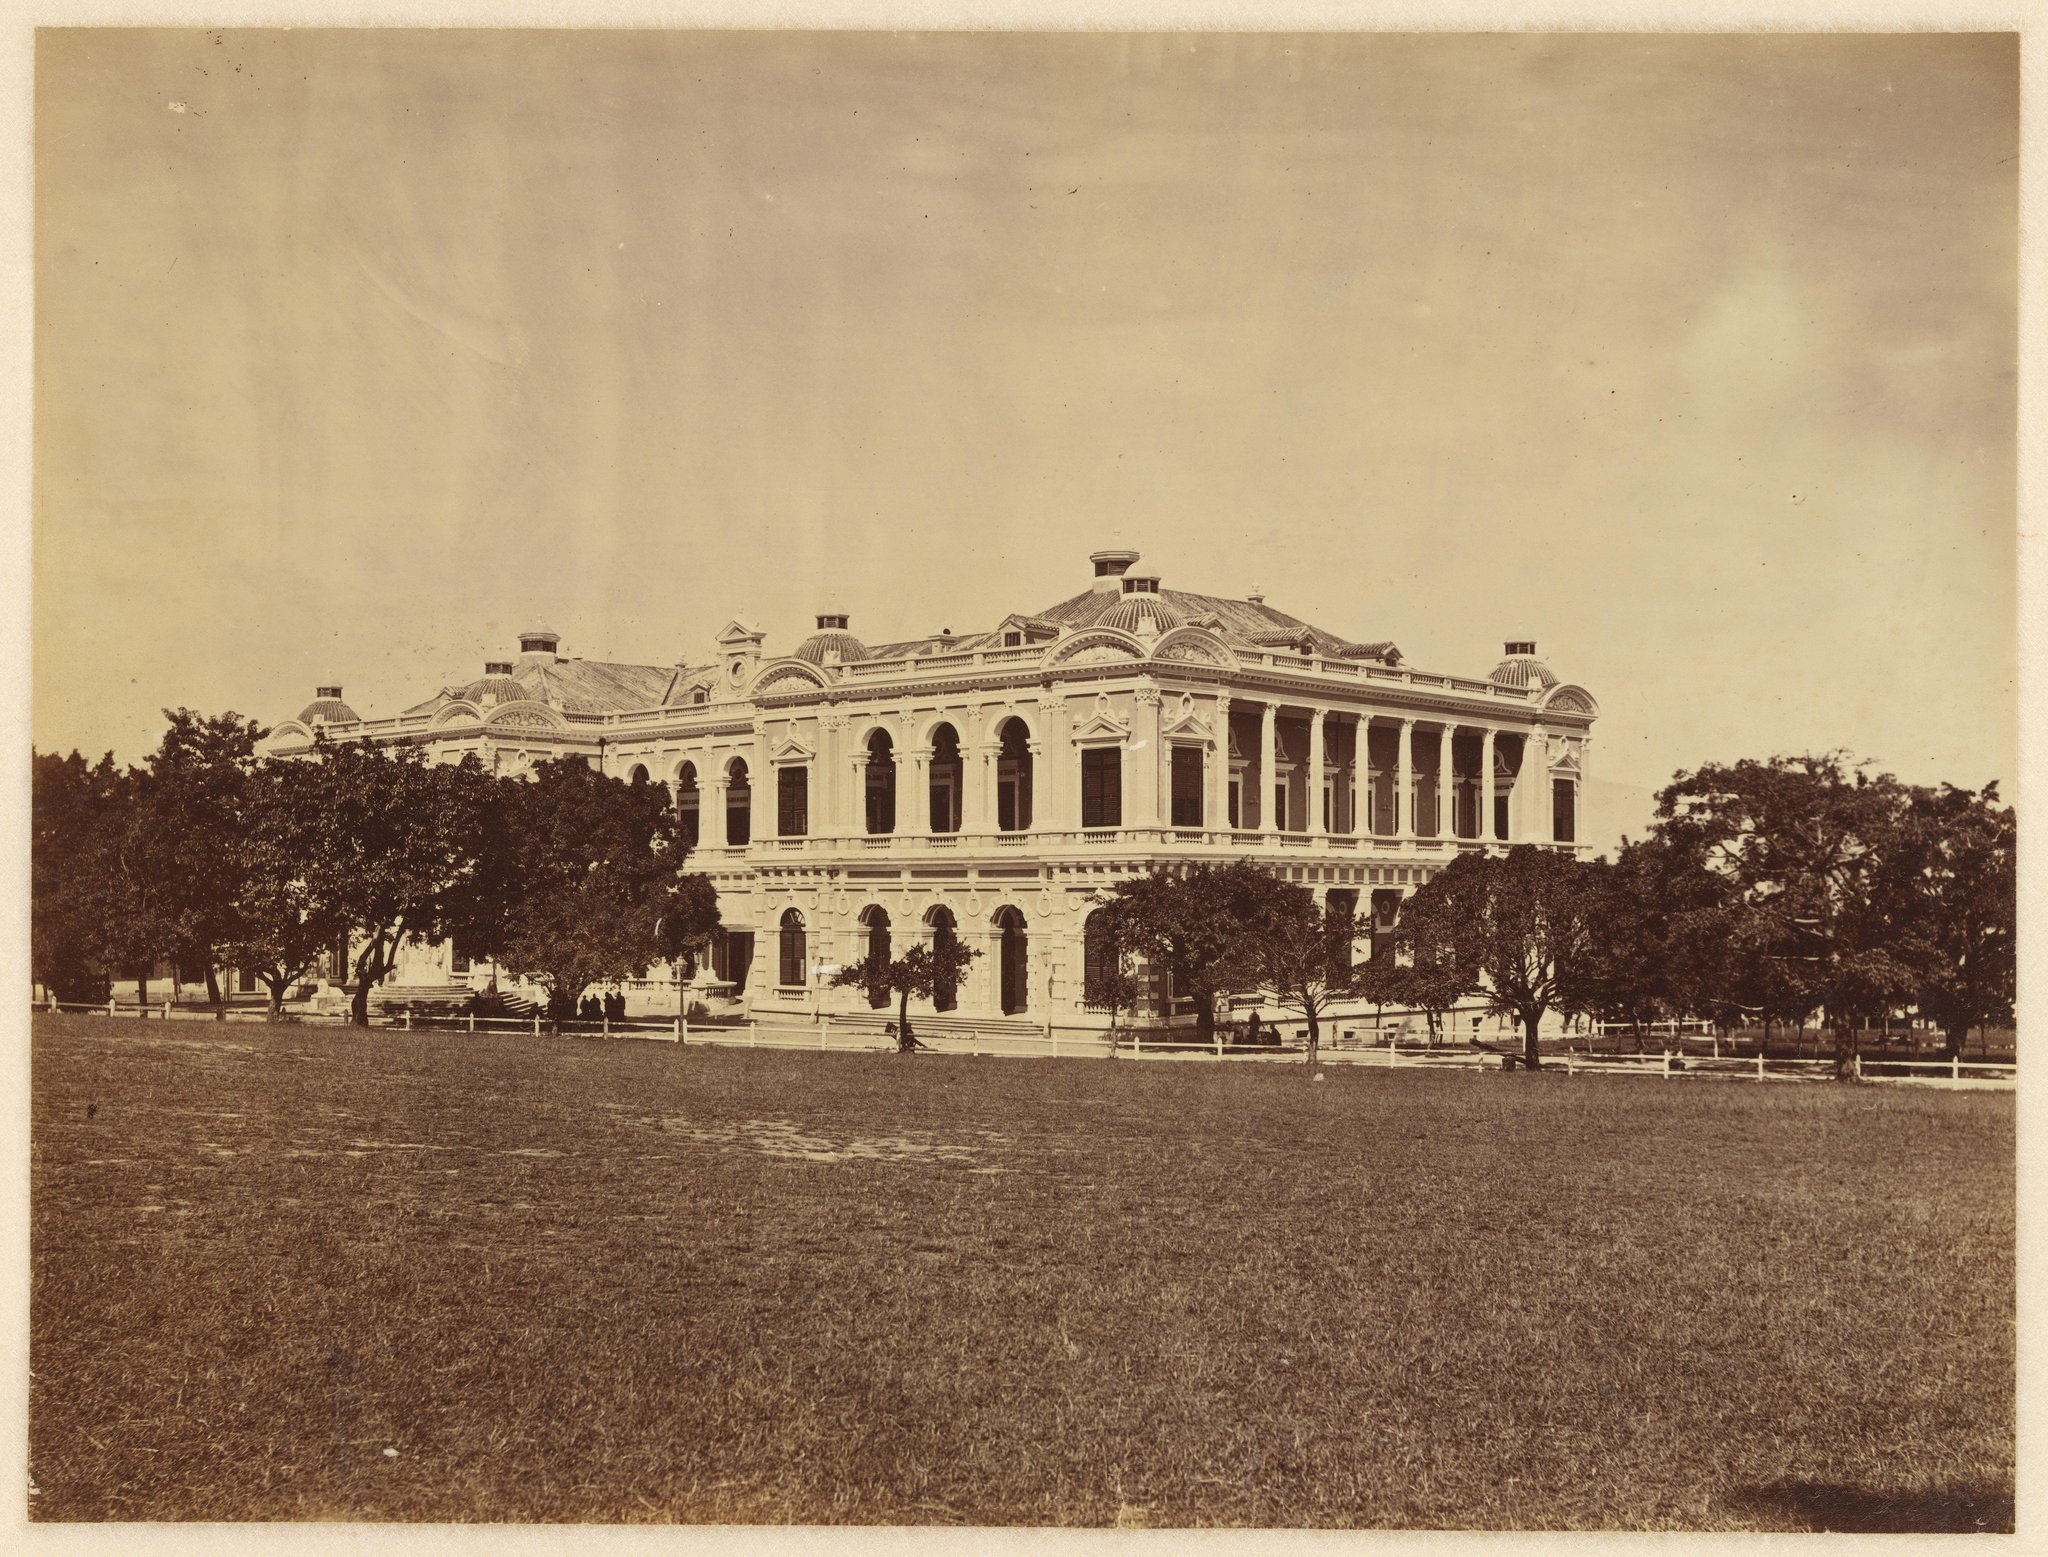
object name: photograph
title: Onbekend gebouw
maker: Anonymous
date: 1865-1870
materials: paper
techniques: albumen print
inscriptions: number: ‘11’, number: ‘346’, inscription: ‘... Hall ...’